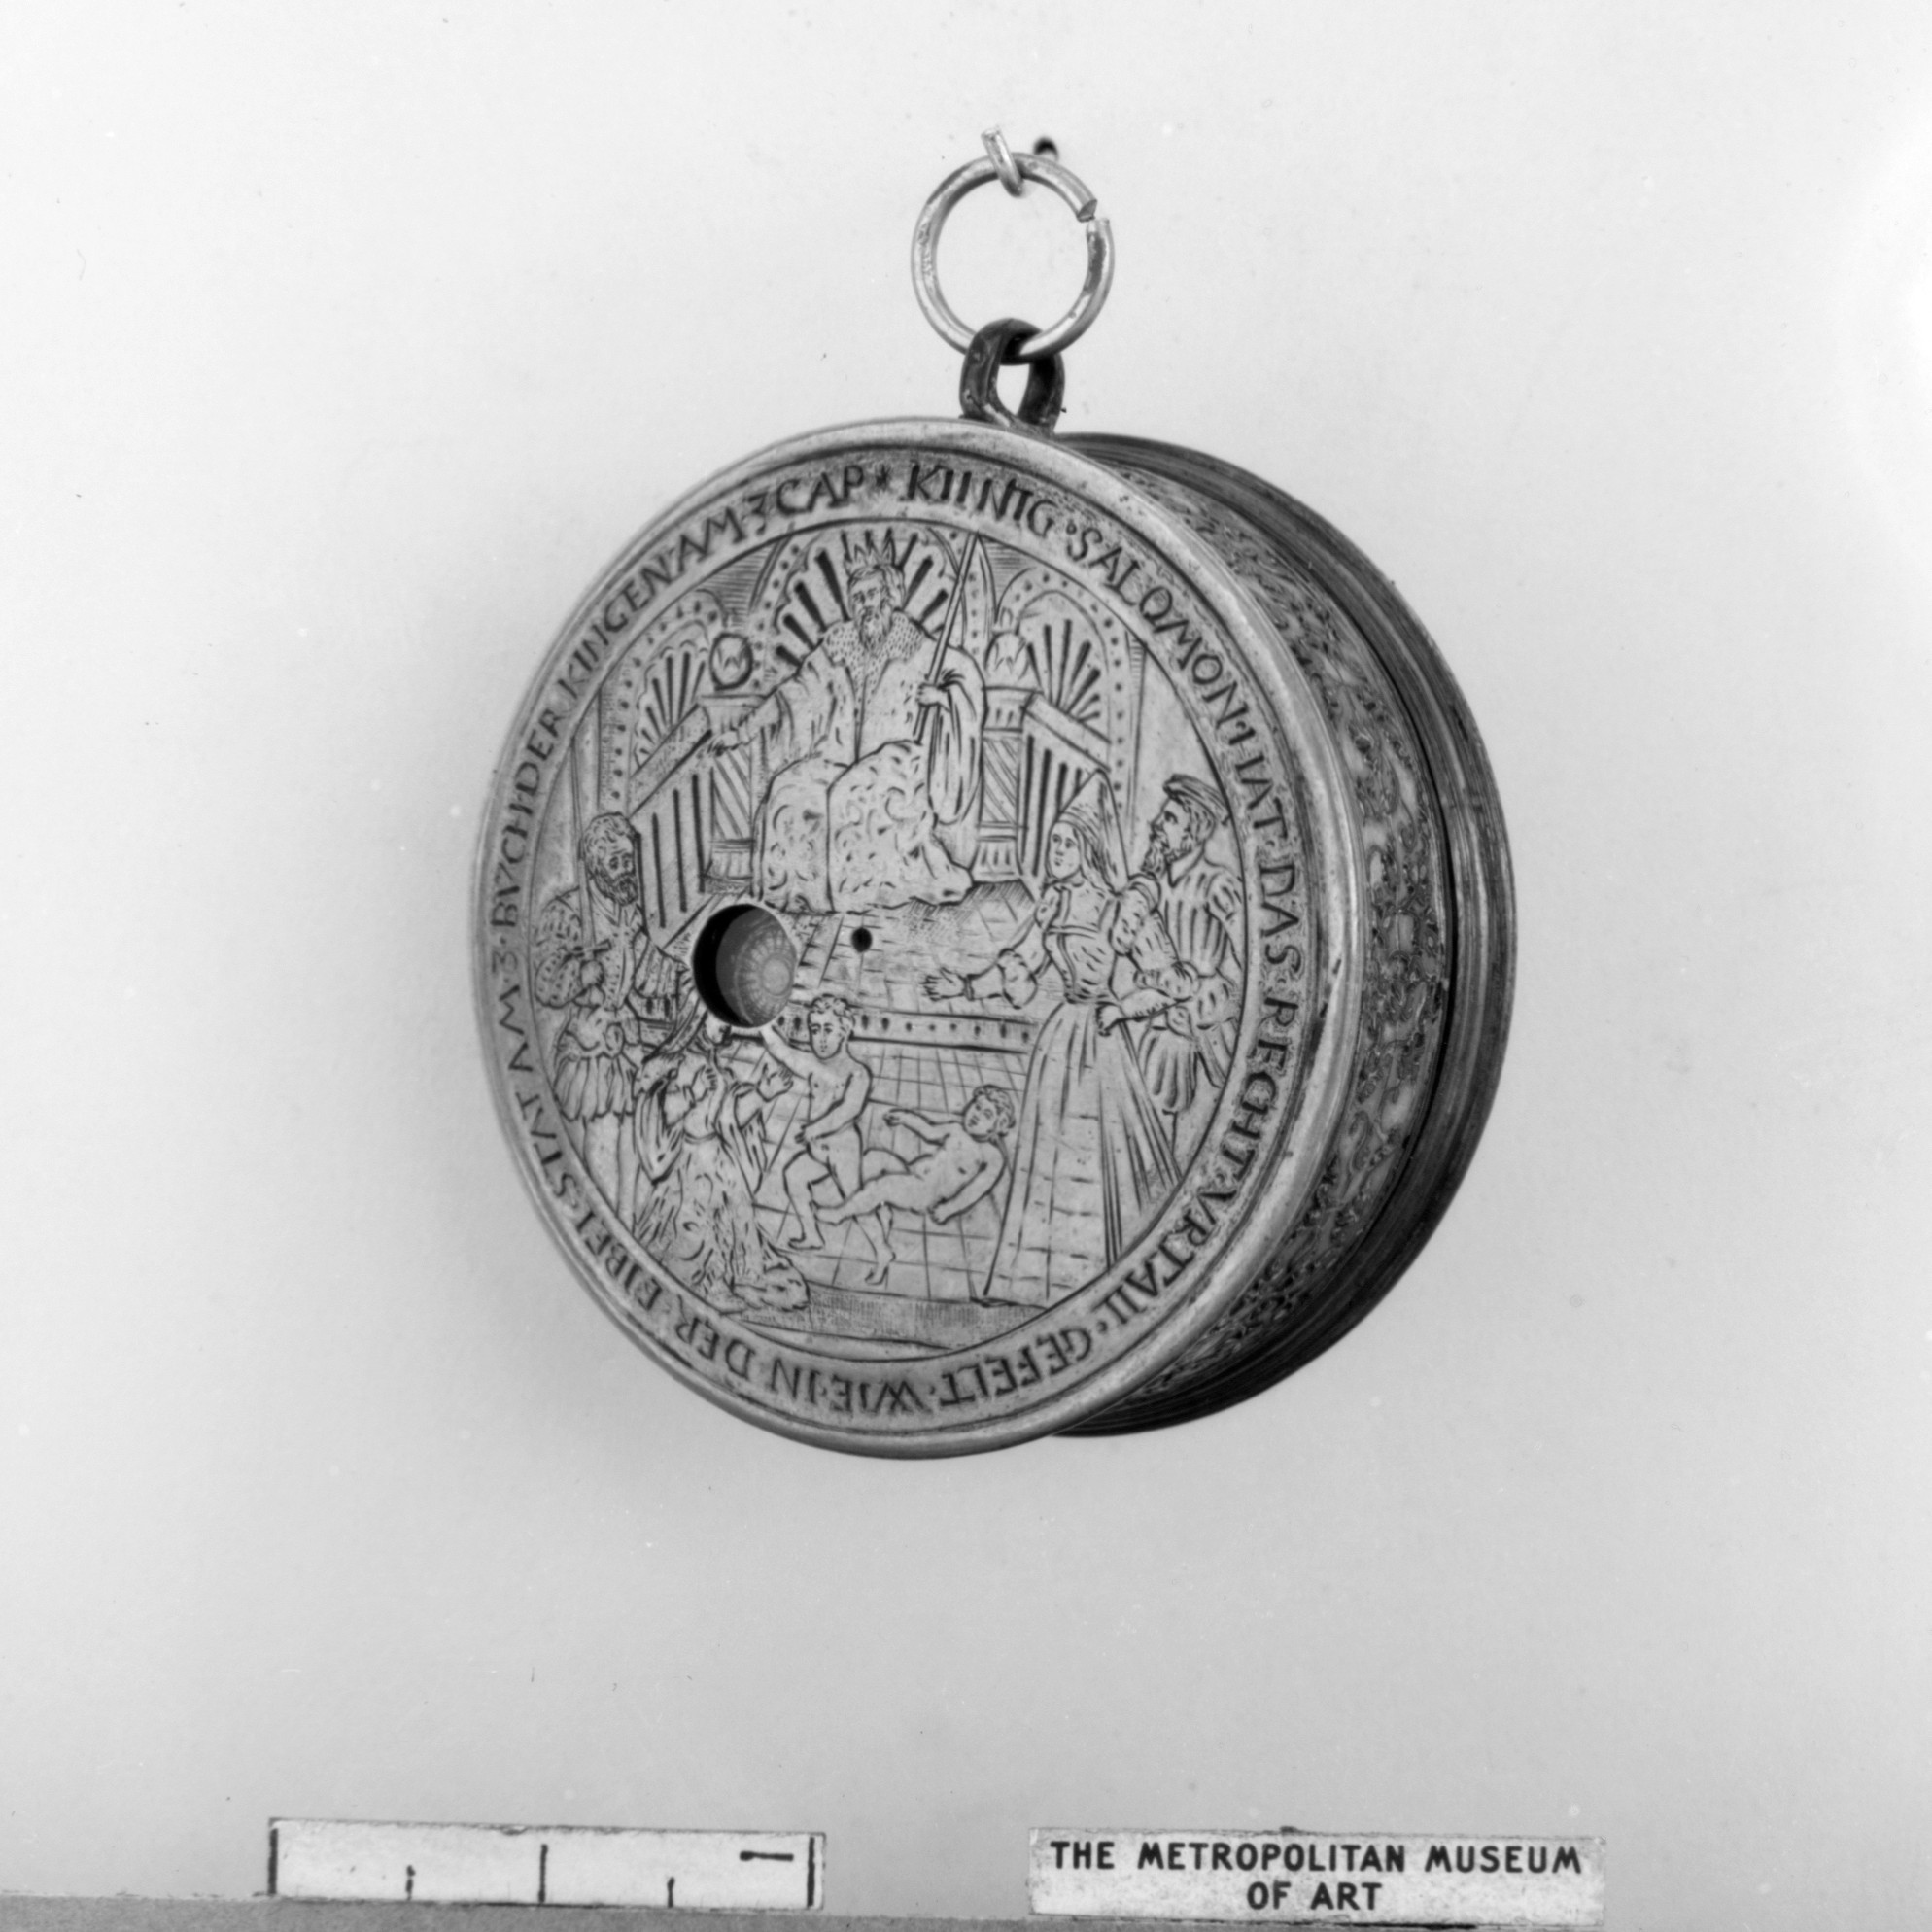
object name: watch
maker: leopold reicheneder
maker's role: maker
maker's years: 1520-1580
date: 1550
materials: gilt, metal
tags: children,men,women